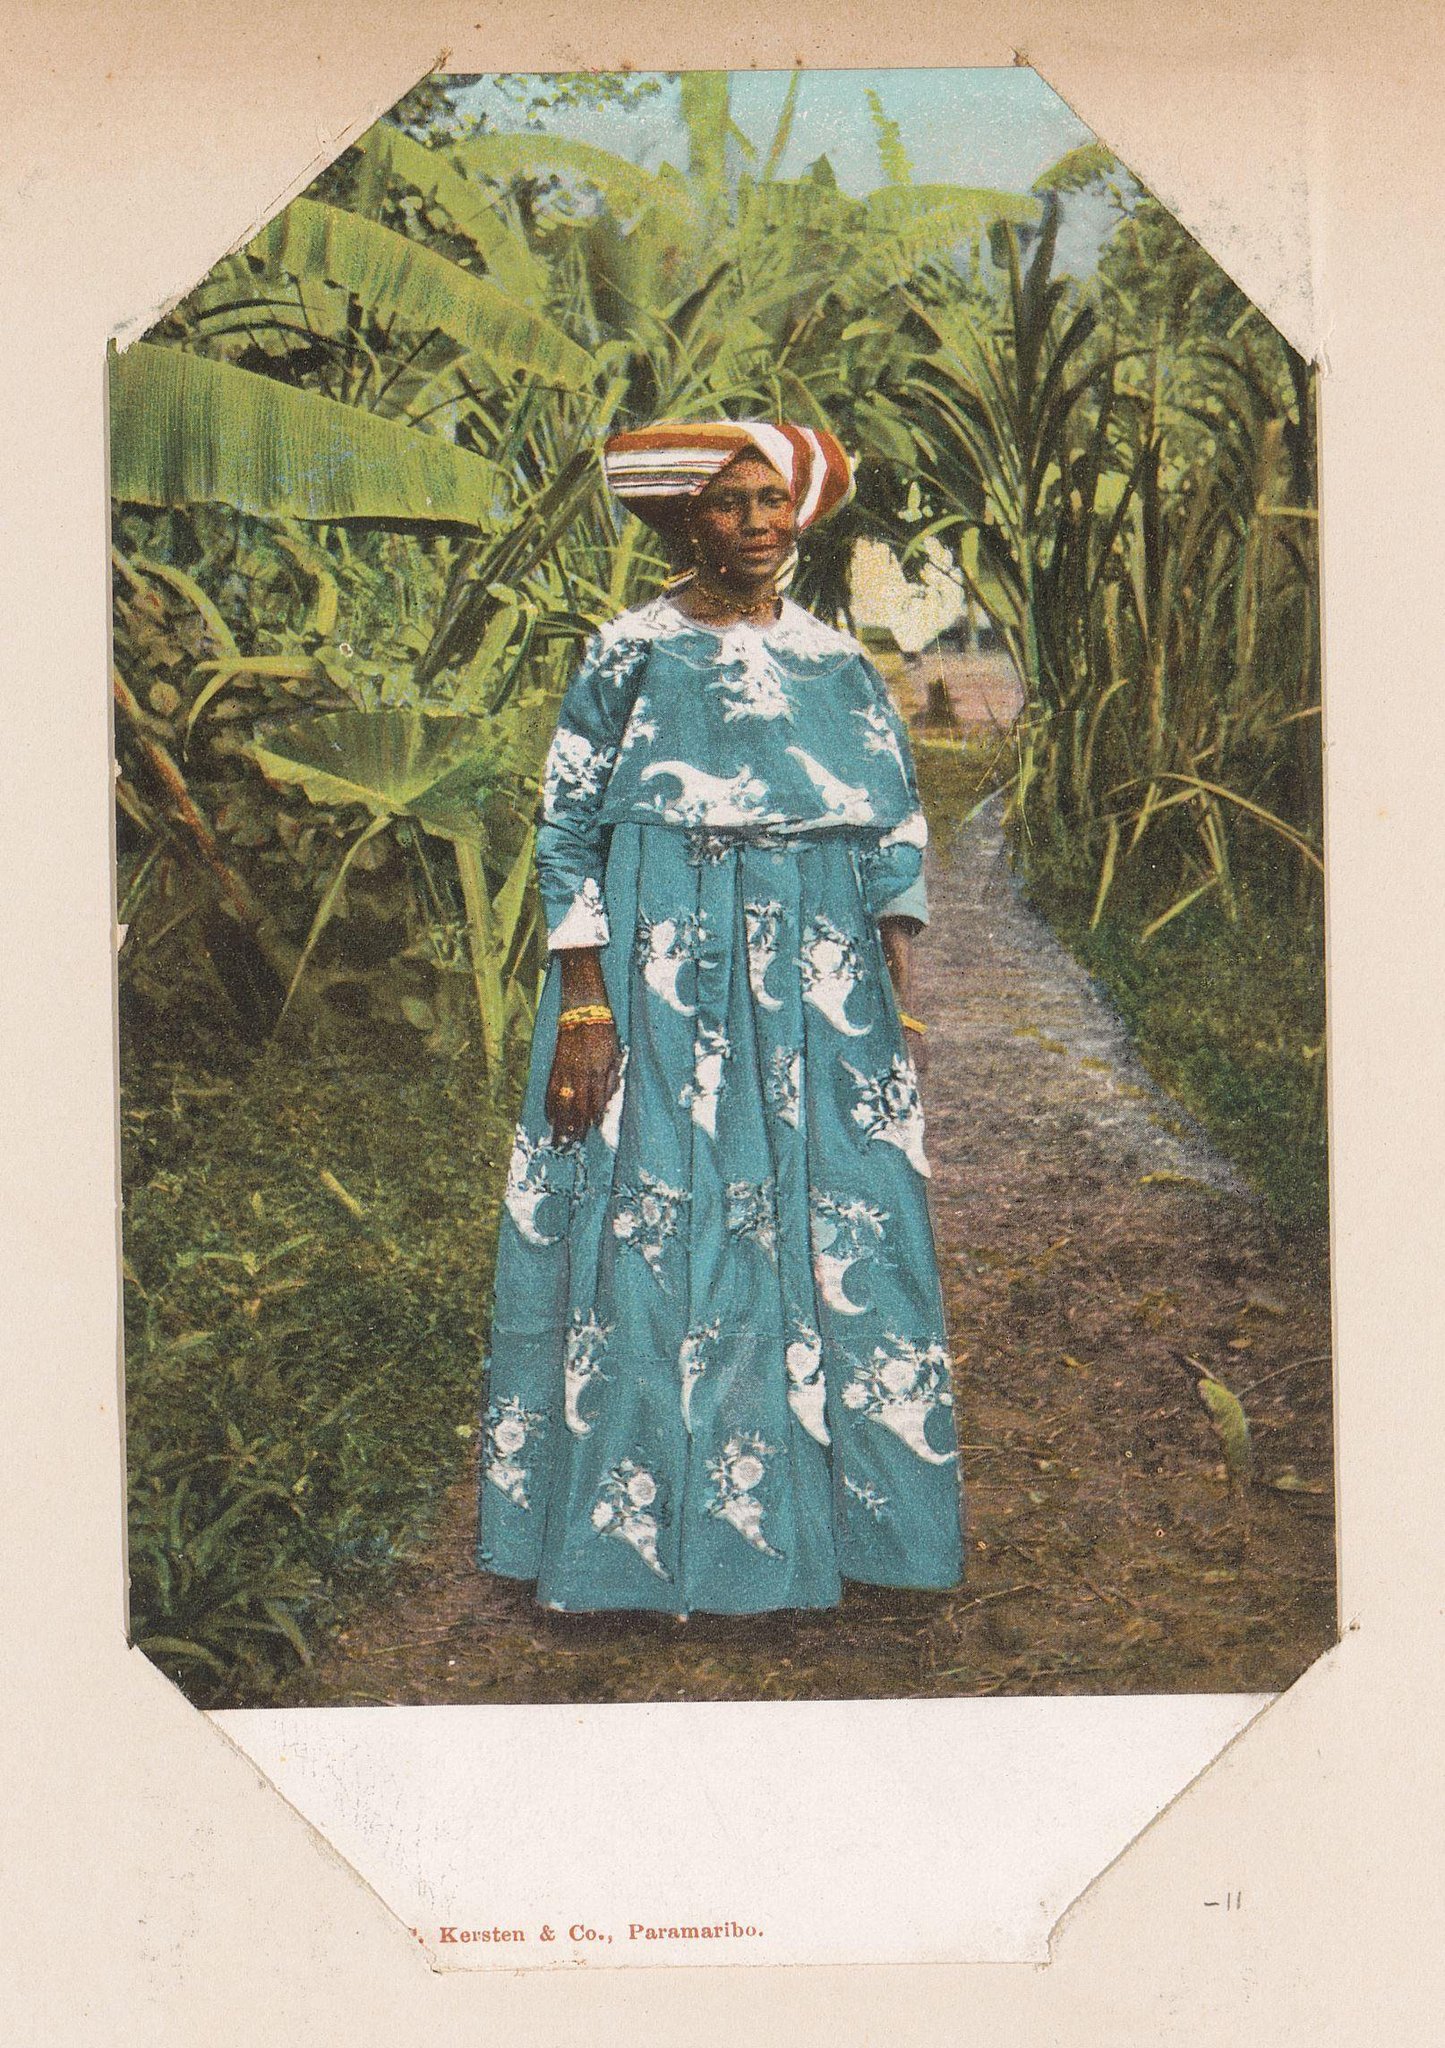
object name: ansichtkaart, prentbriefkaart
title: Staande vrouw in koto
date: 1900-1910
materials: cardboard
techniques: autotype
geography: paramaribo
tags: folk costume, regional costume, suriname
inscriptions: serial number: ‘No. 72. Uitgevers C. Kersten & Co., Paramaribo’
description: Portret van een staande Surinaamse vrouw in koto. Onderdeel van een verzameling van 68 briefkaarten uit Suriname, bijeengebracht in een album als aandenken aan een verblijf in Suriname in september 1911.